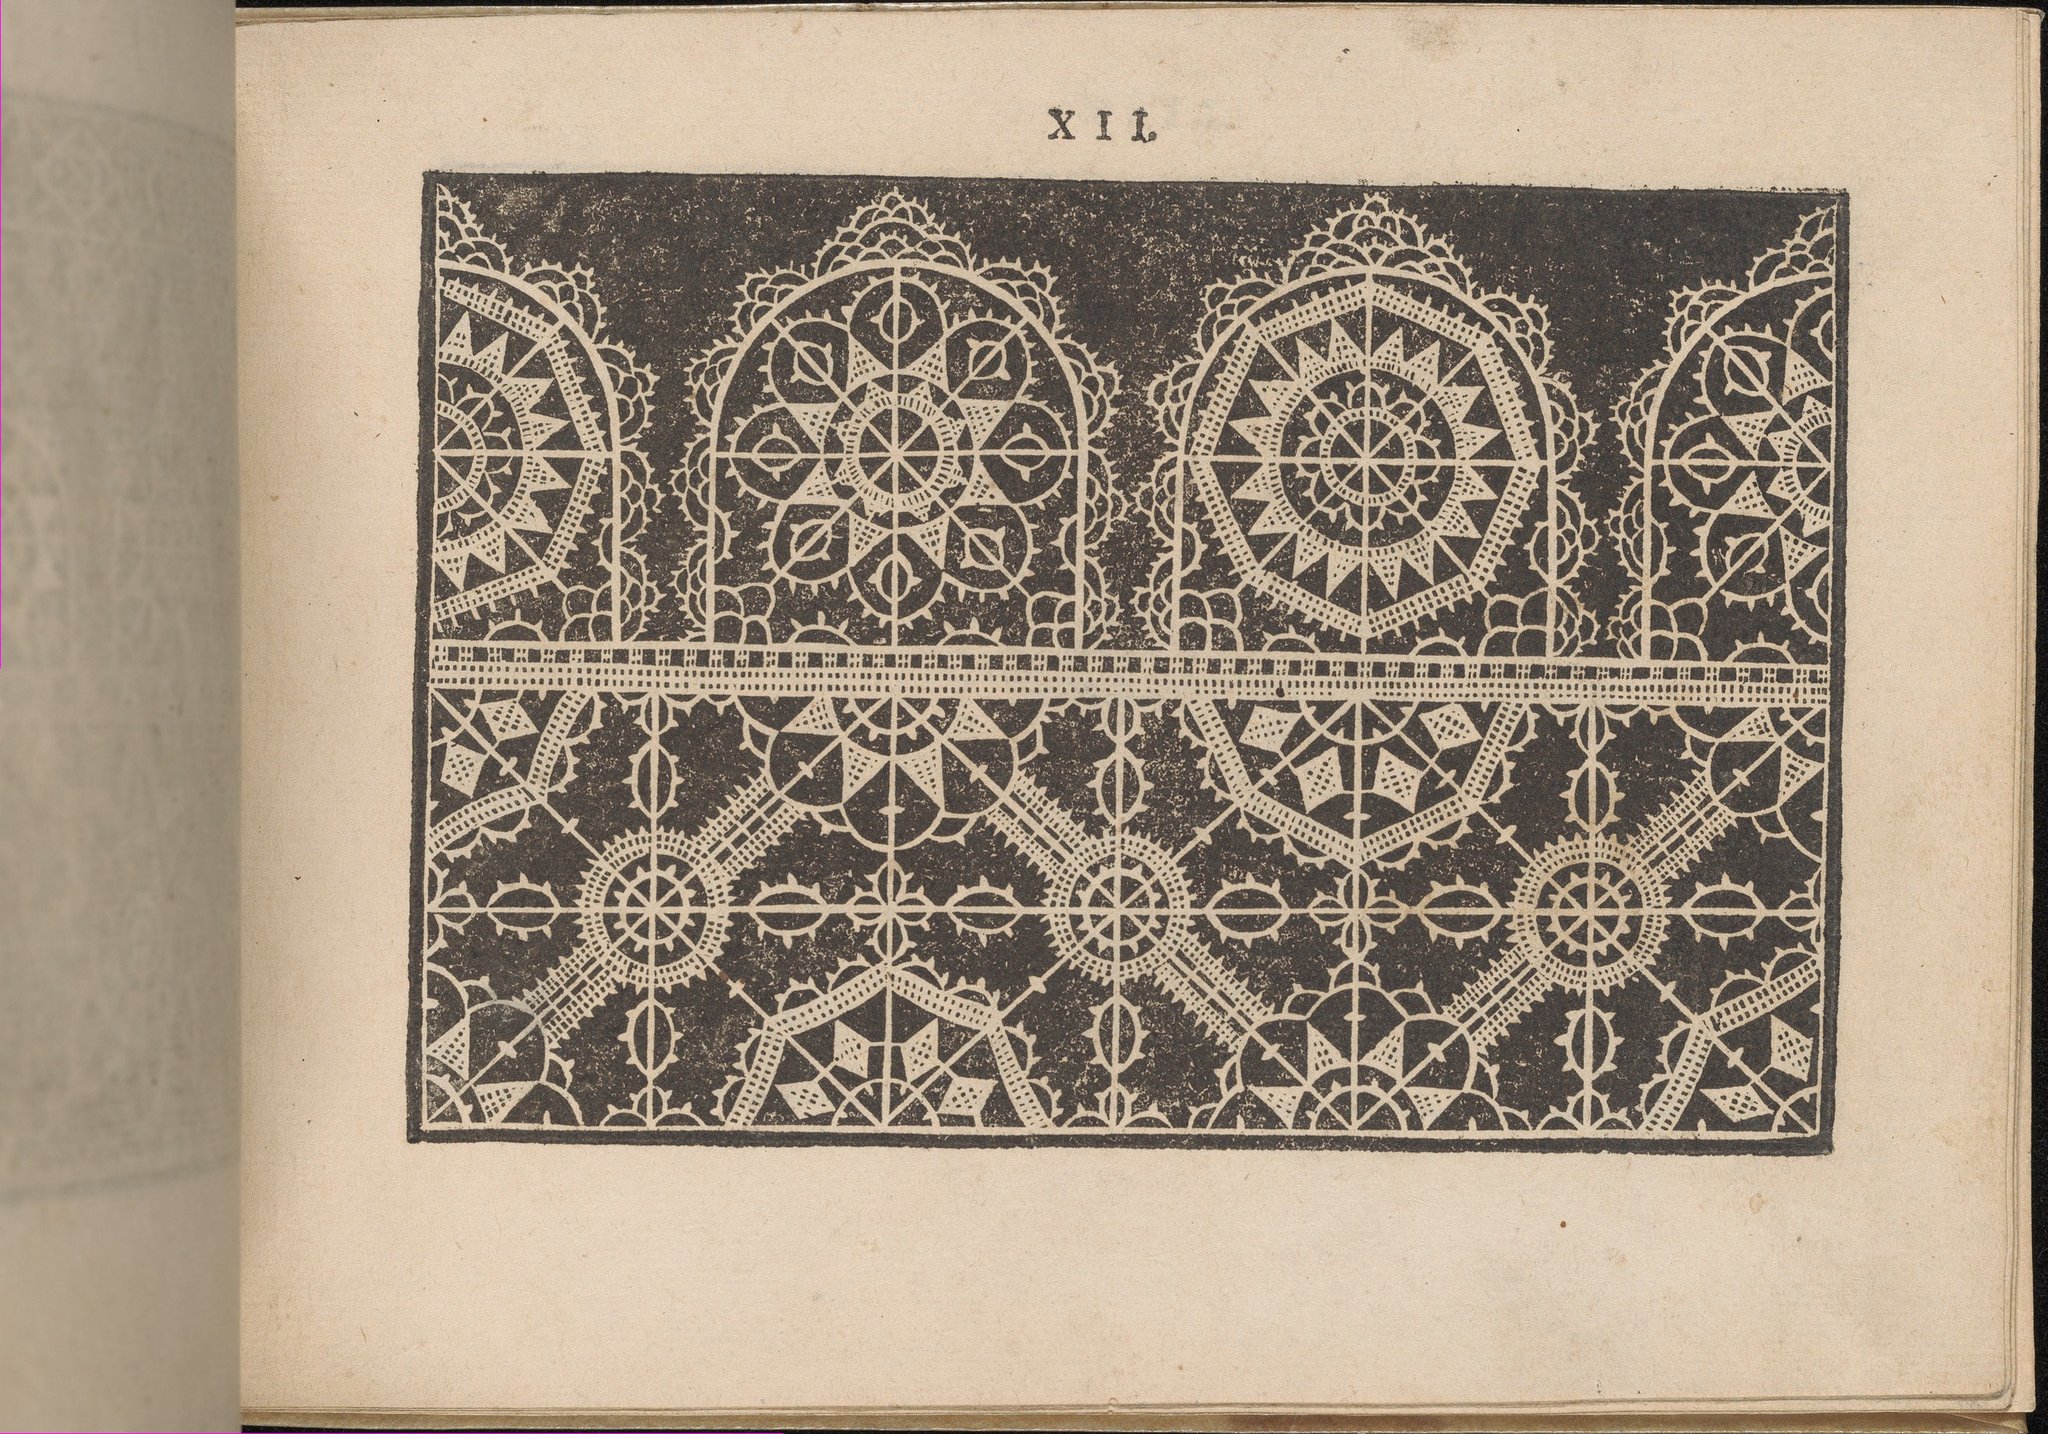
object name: book print ornament architecture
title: Prima Parte de' Fiori, e Disegni di varie sorti di Ricami Moderni, page 12 (recto)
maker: giovanni battista ciotti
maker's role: author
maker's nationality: italian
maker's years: 1555-1659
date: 1591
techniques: woodcut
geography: italy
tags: ornament